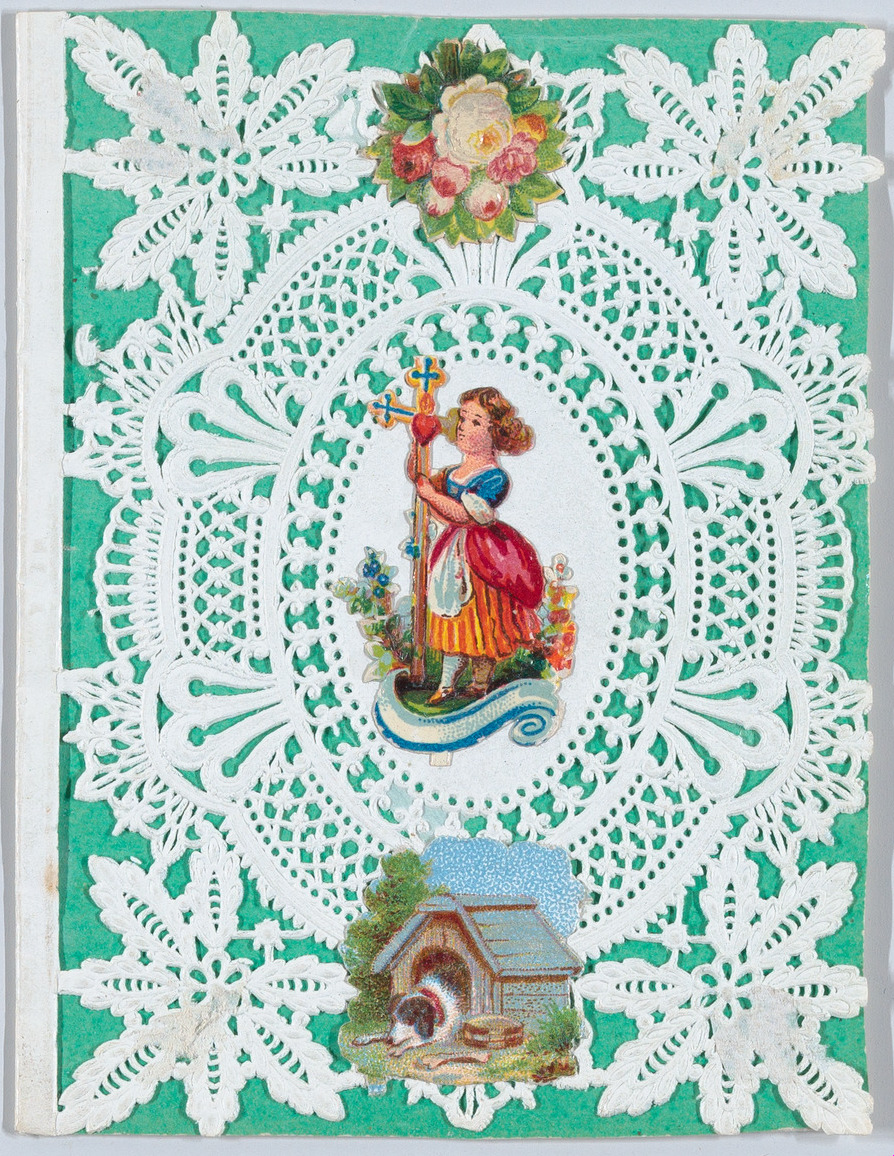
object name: valentine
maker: esther howland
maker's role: artist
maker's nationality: american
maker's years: 1828-1904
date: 1847-1870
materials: ink, lace, paper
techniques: cutting, embossing